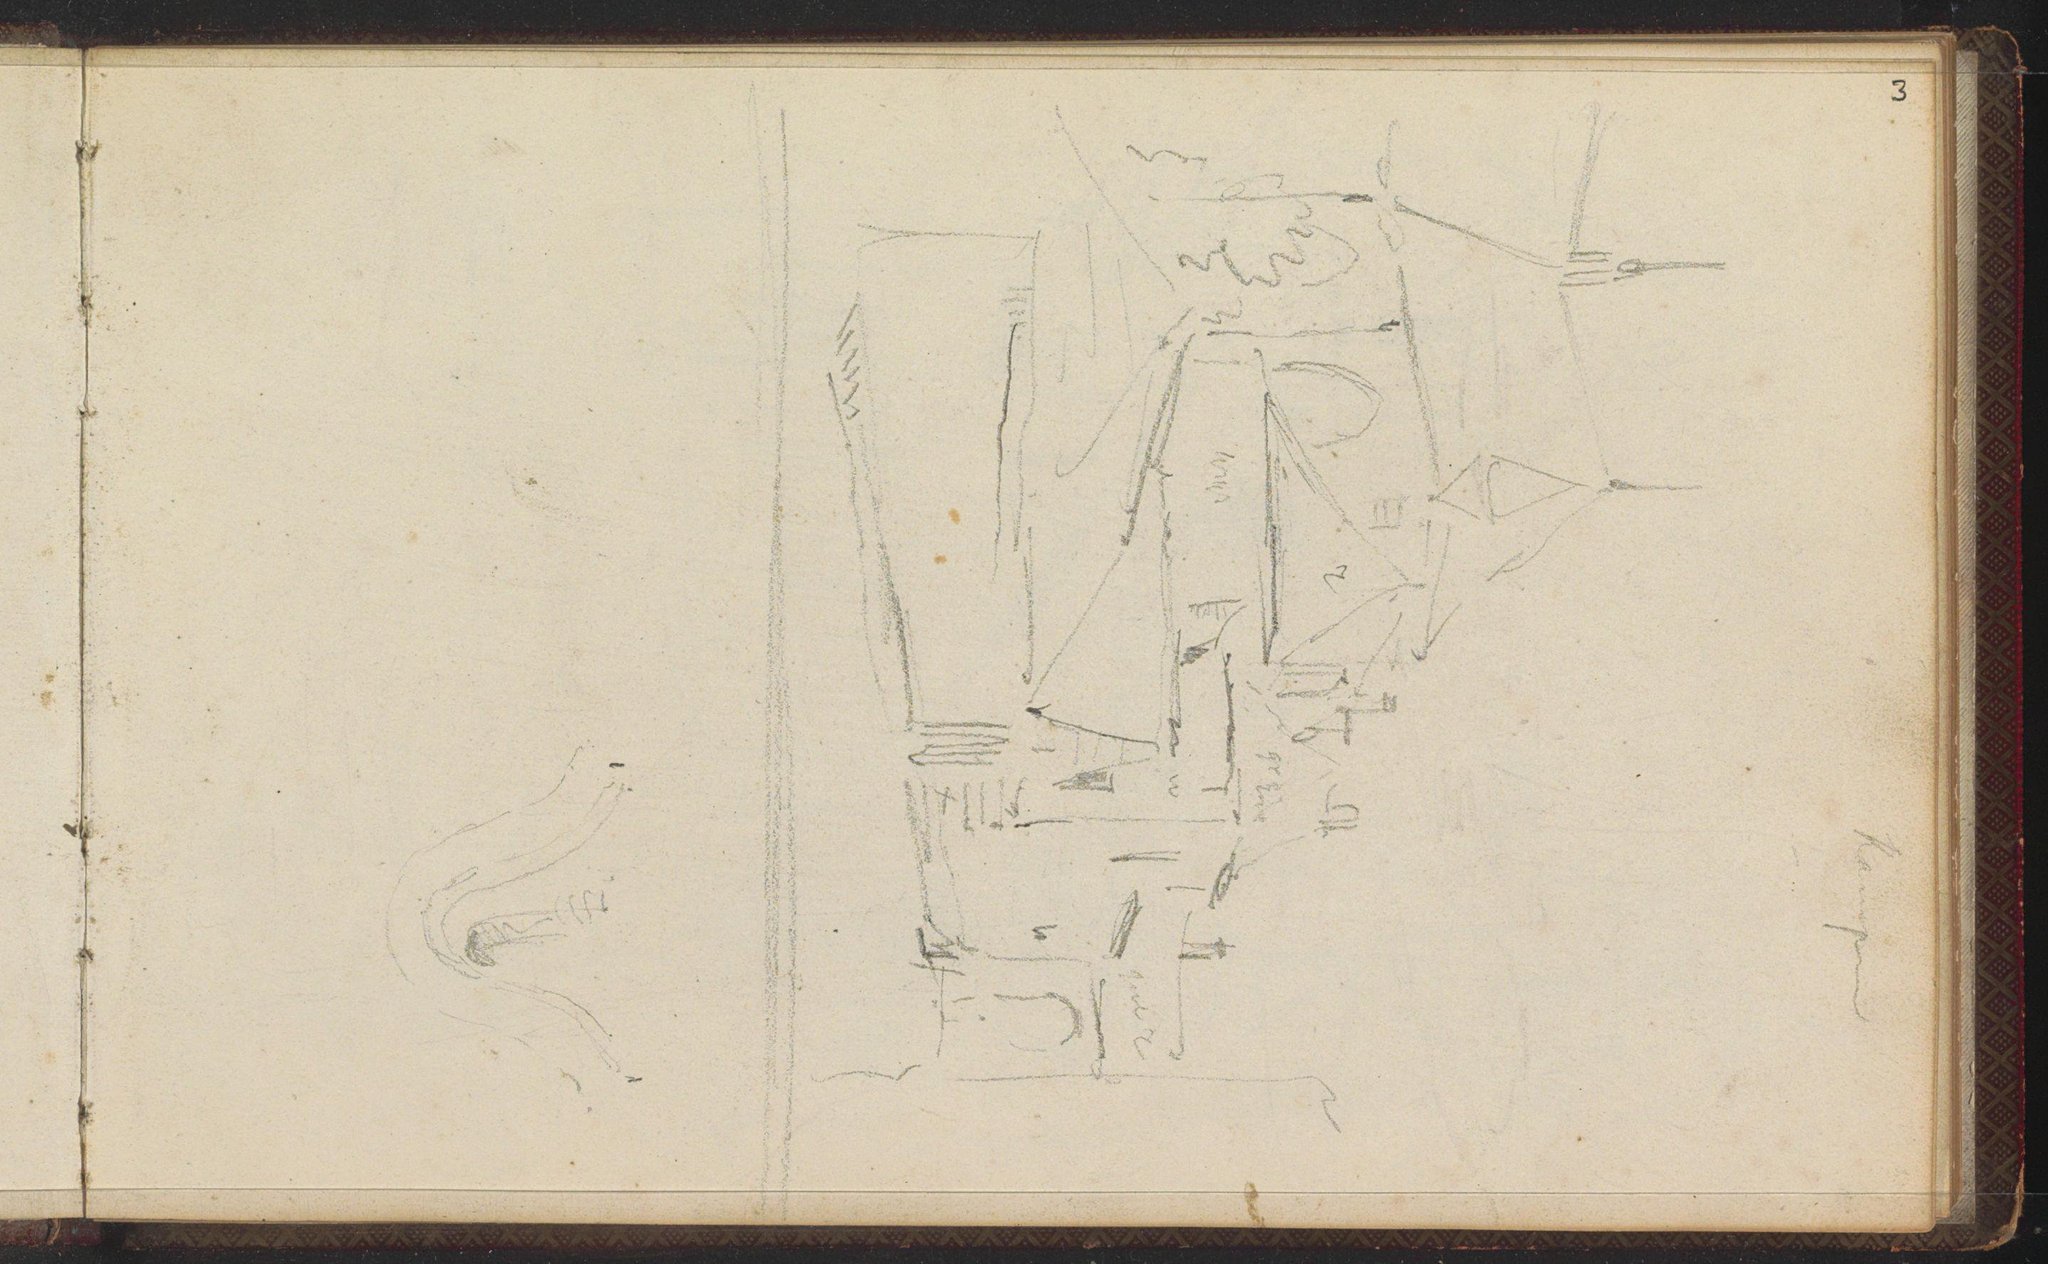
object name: sketchbook leaf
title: Gezicht in Kampen, mogelijk met de Bovenkerk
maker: adrianus eversen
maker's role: draughtsman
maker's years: 1818-1897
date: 1828-1897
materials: paper, pencil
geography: kampen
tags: city-view, and landscape with man-made constructions, decorated gable, church (exterior)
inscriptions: annotation: ‘Kampen’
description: Gezicht in Kampen, mogelijk met de Bovenkerk. Daaronder een studie van een klokgevel. Blad 3 recto uit een schetsboek met 52 bladen vervaardigd in de omgeving van Kampen, Hattem, Hoorn en Zwolle.